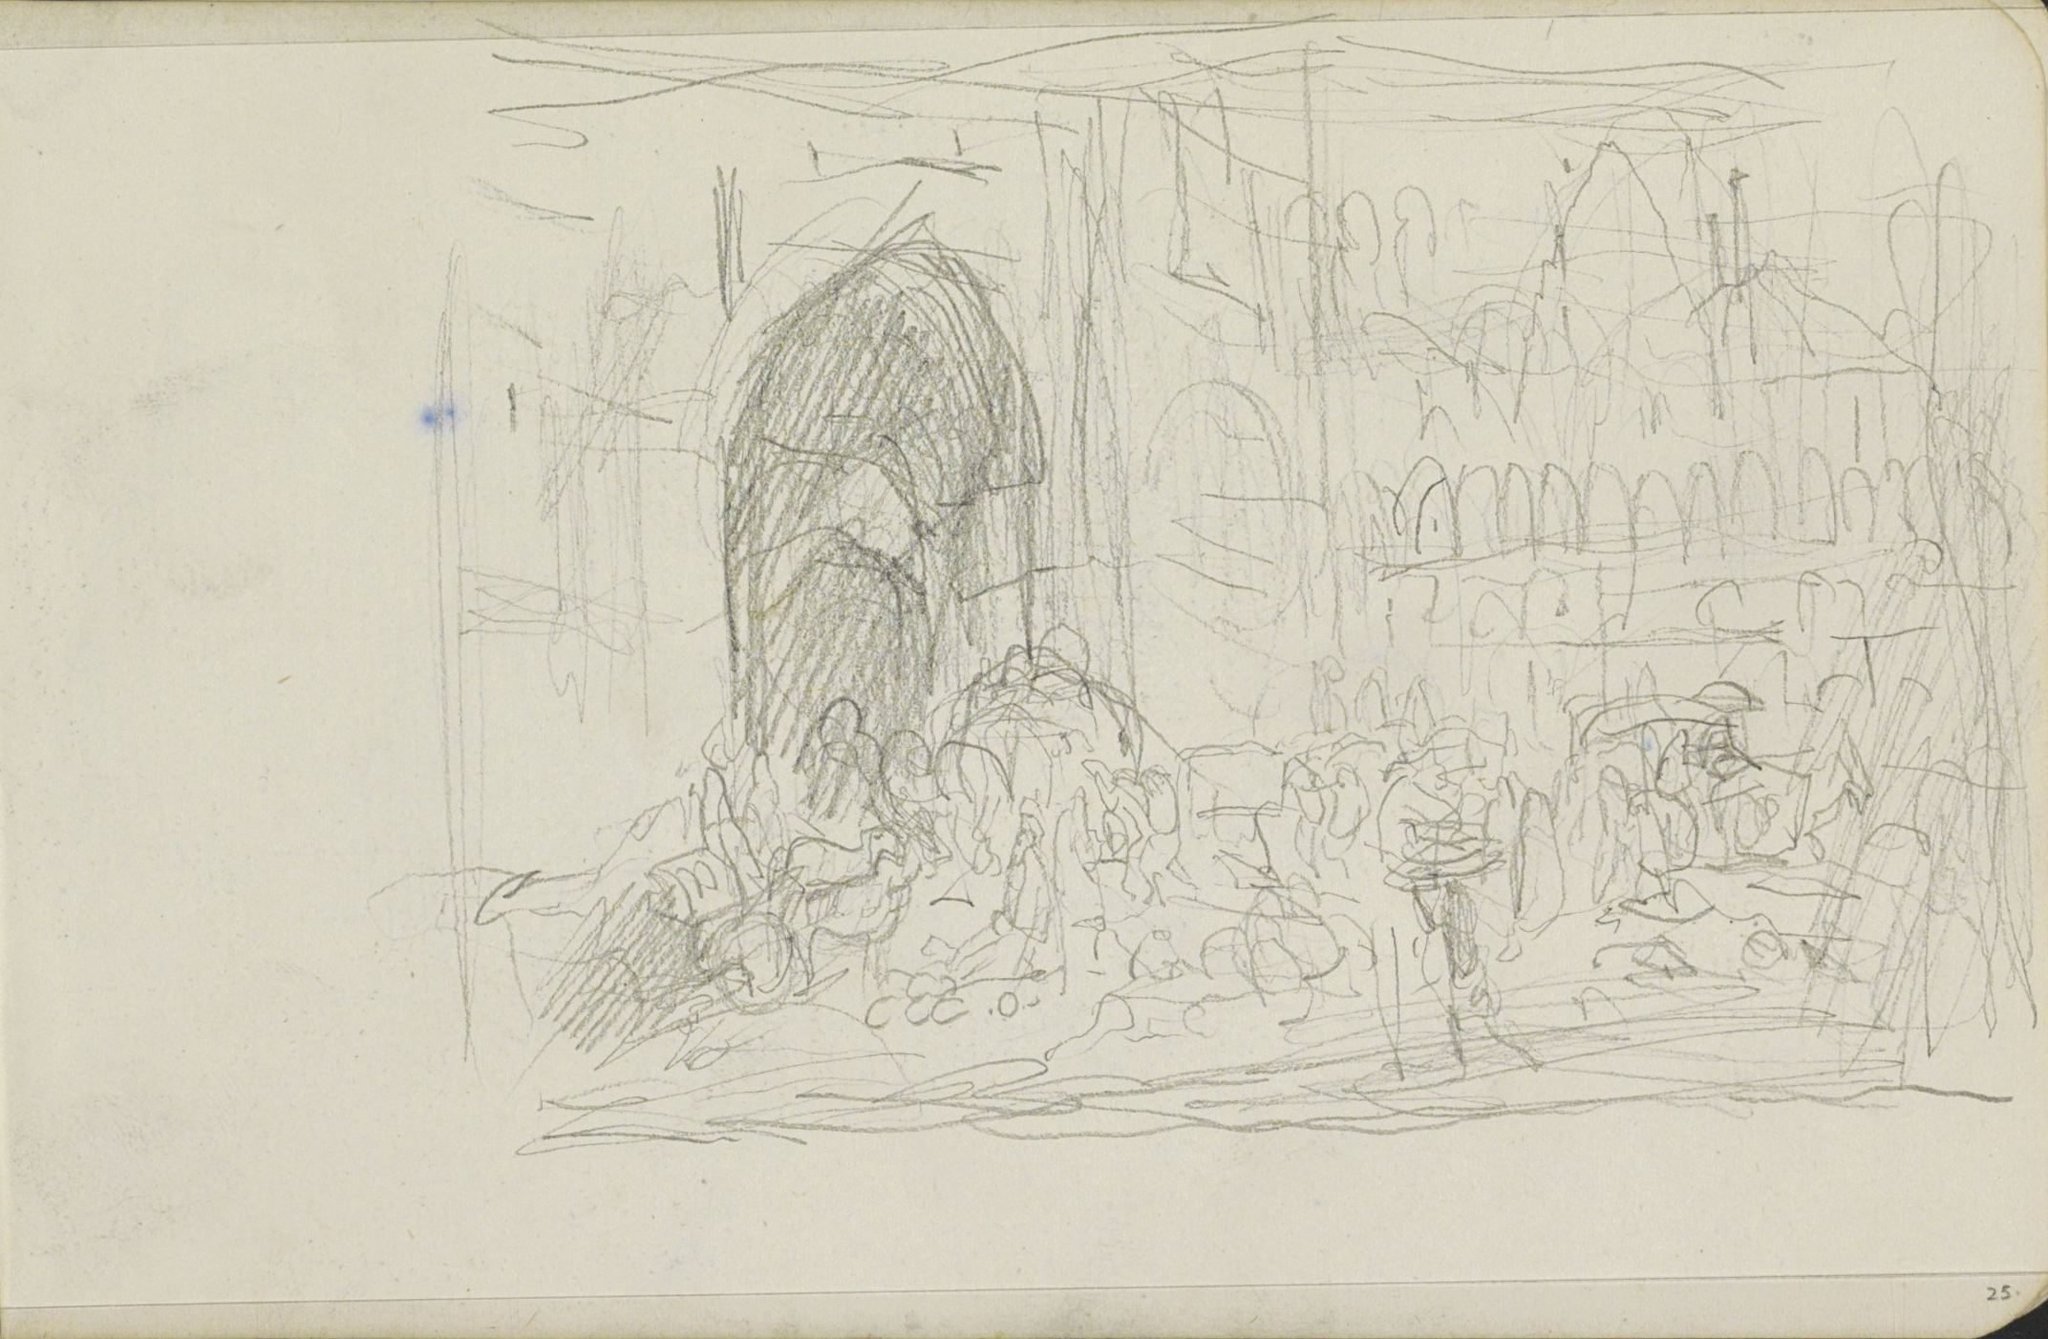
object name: sketchbook leaf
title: Straat met figuren bij een kerkportaal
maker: marius bauer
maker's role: draughtsman, print maker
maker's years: 1867-1932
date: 1902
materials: paper, pencil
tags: parts of church exterior and annexes: portal, street (+ city(-scape) with figures, staffage)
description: Pagina 25 uit een schetsboek met 15 bladen.